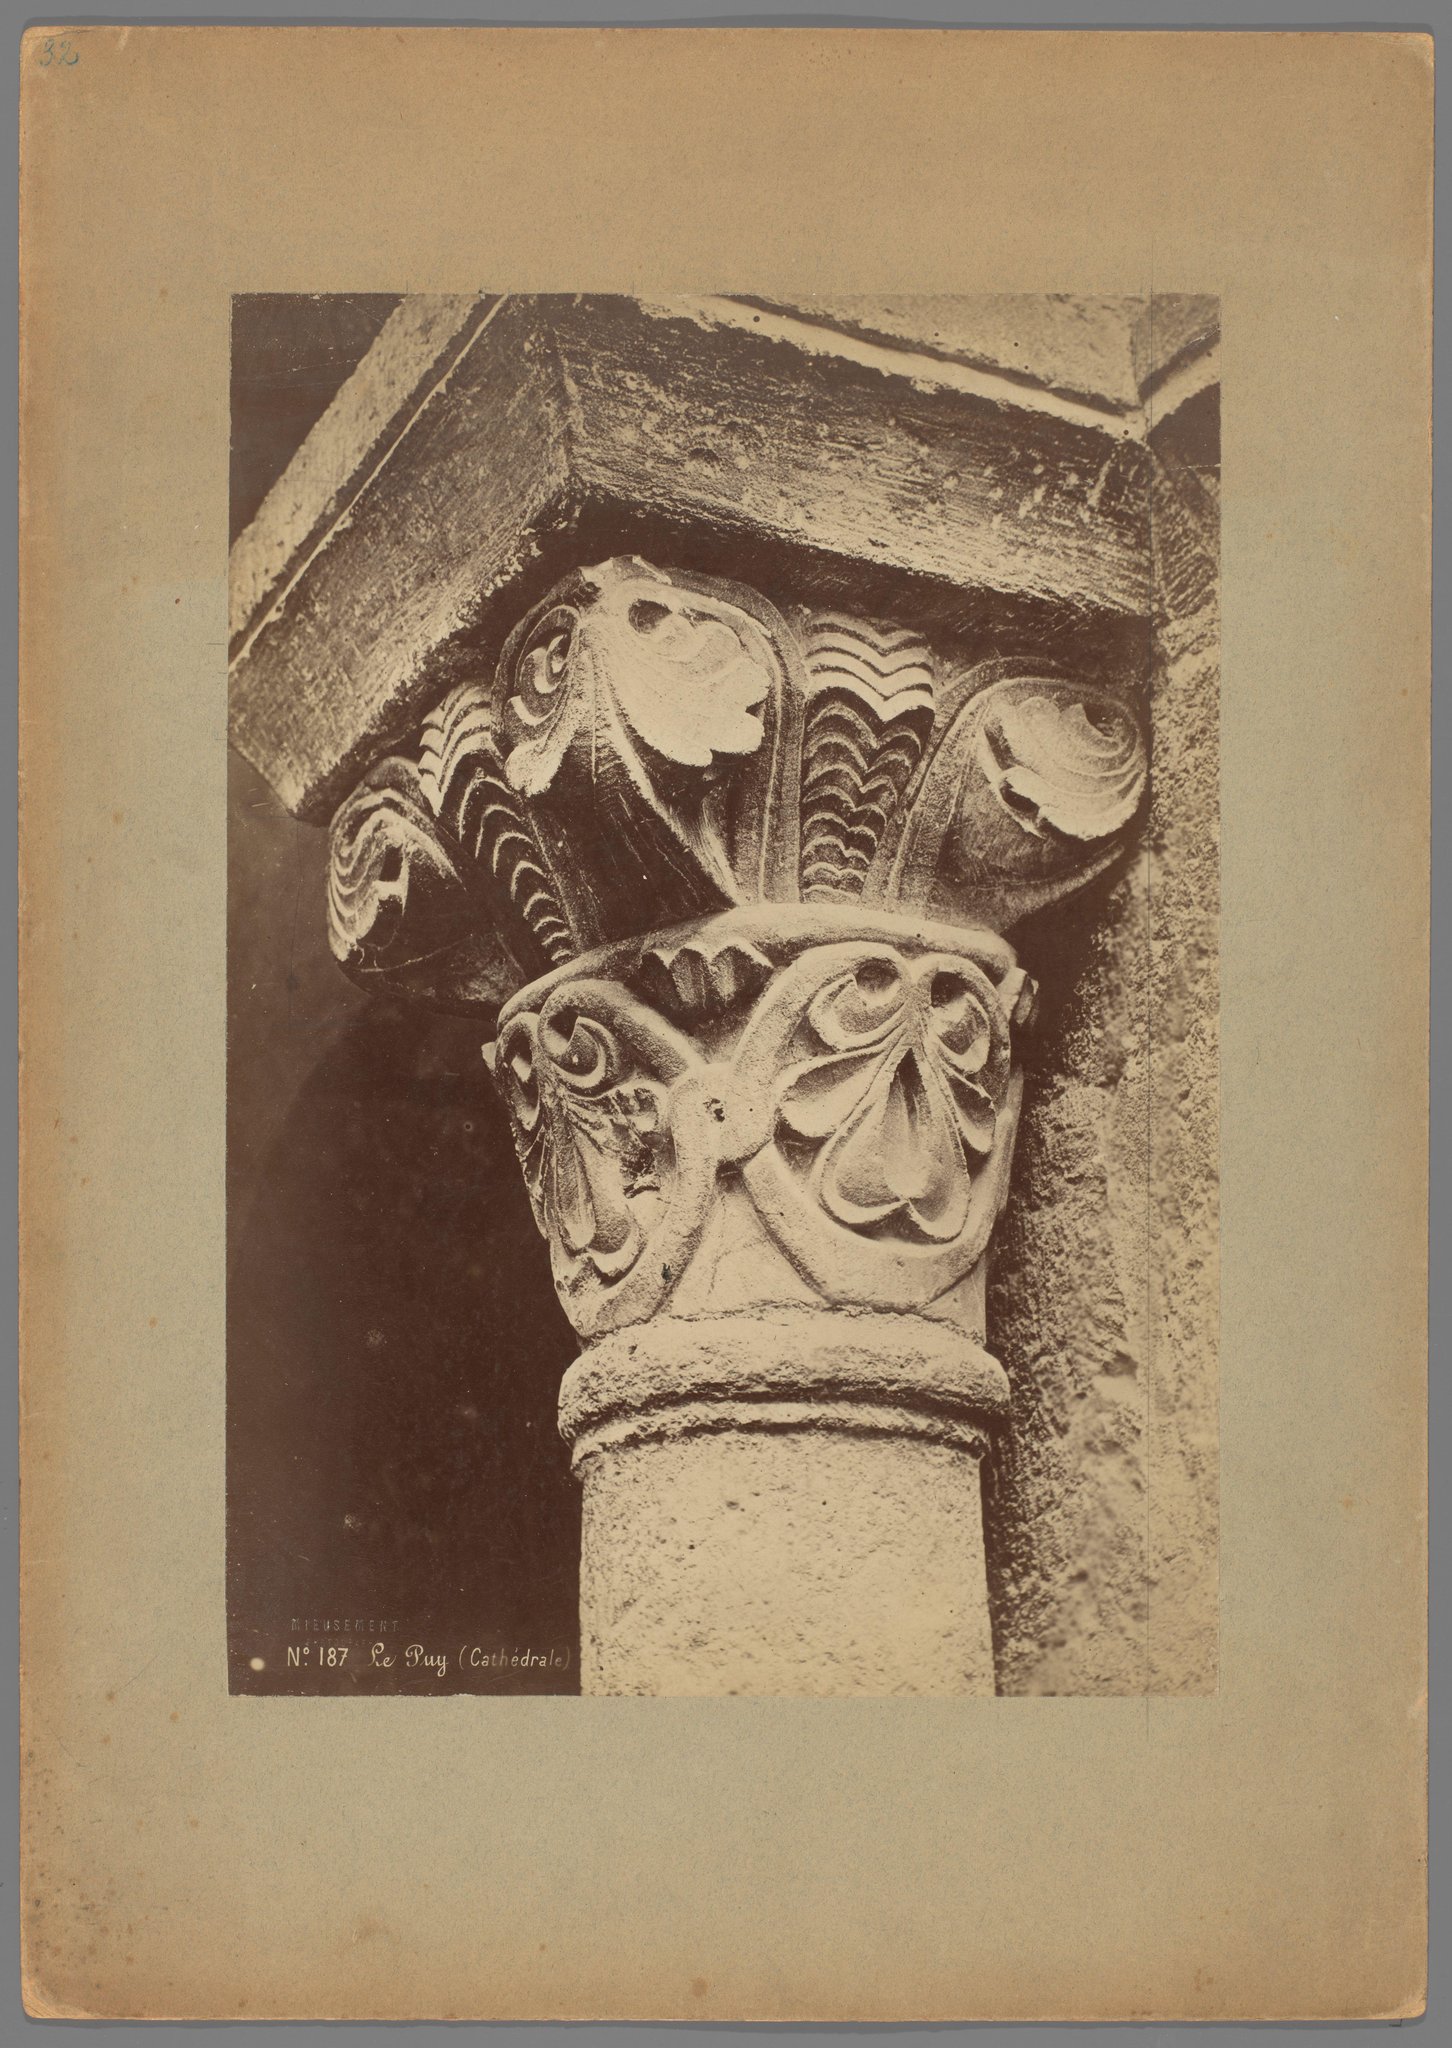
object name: photograph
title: Le Puy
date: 1850-1900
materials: cardboard, photographic support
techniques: albumen print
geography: the hague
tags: capital (~ column, pillar), corinthian order ~ architecture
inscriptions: check stamp: ‘[...]’, collector's mark: ‘Rijks-normaalschool voor teekenonderwijzers Amsterdam’, workshop stamp: ‘Kunsthandel/ J.A.G. de Leur/ Photograaf- Uitgever/ Huigenspark, 40b,/ Den Haag’, number: ‘No. 187’, inscription: ‘(Cathédrale)’